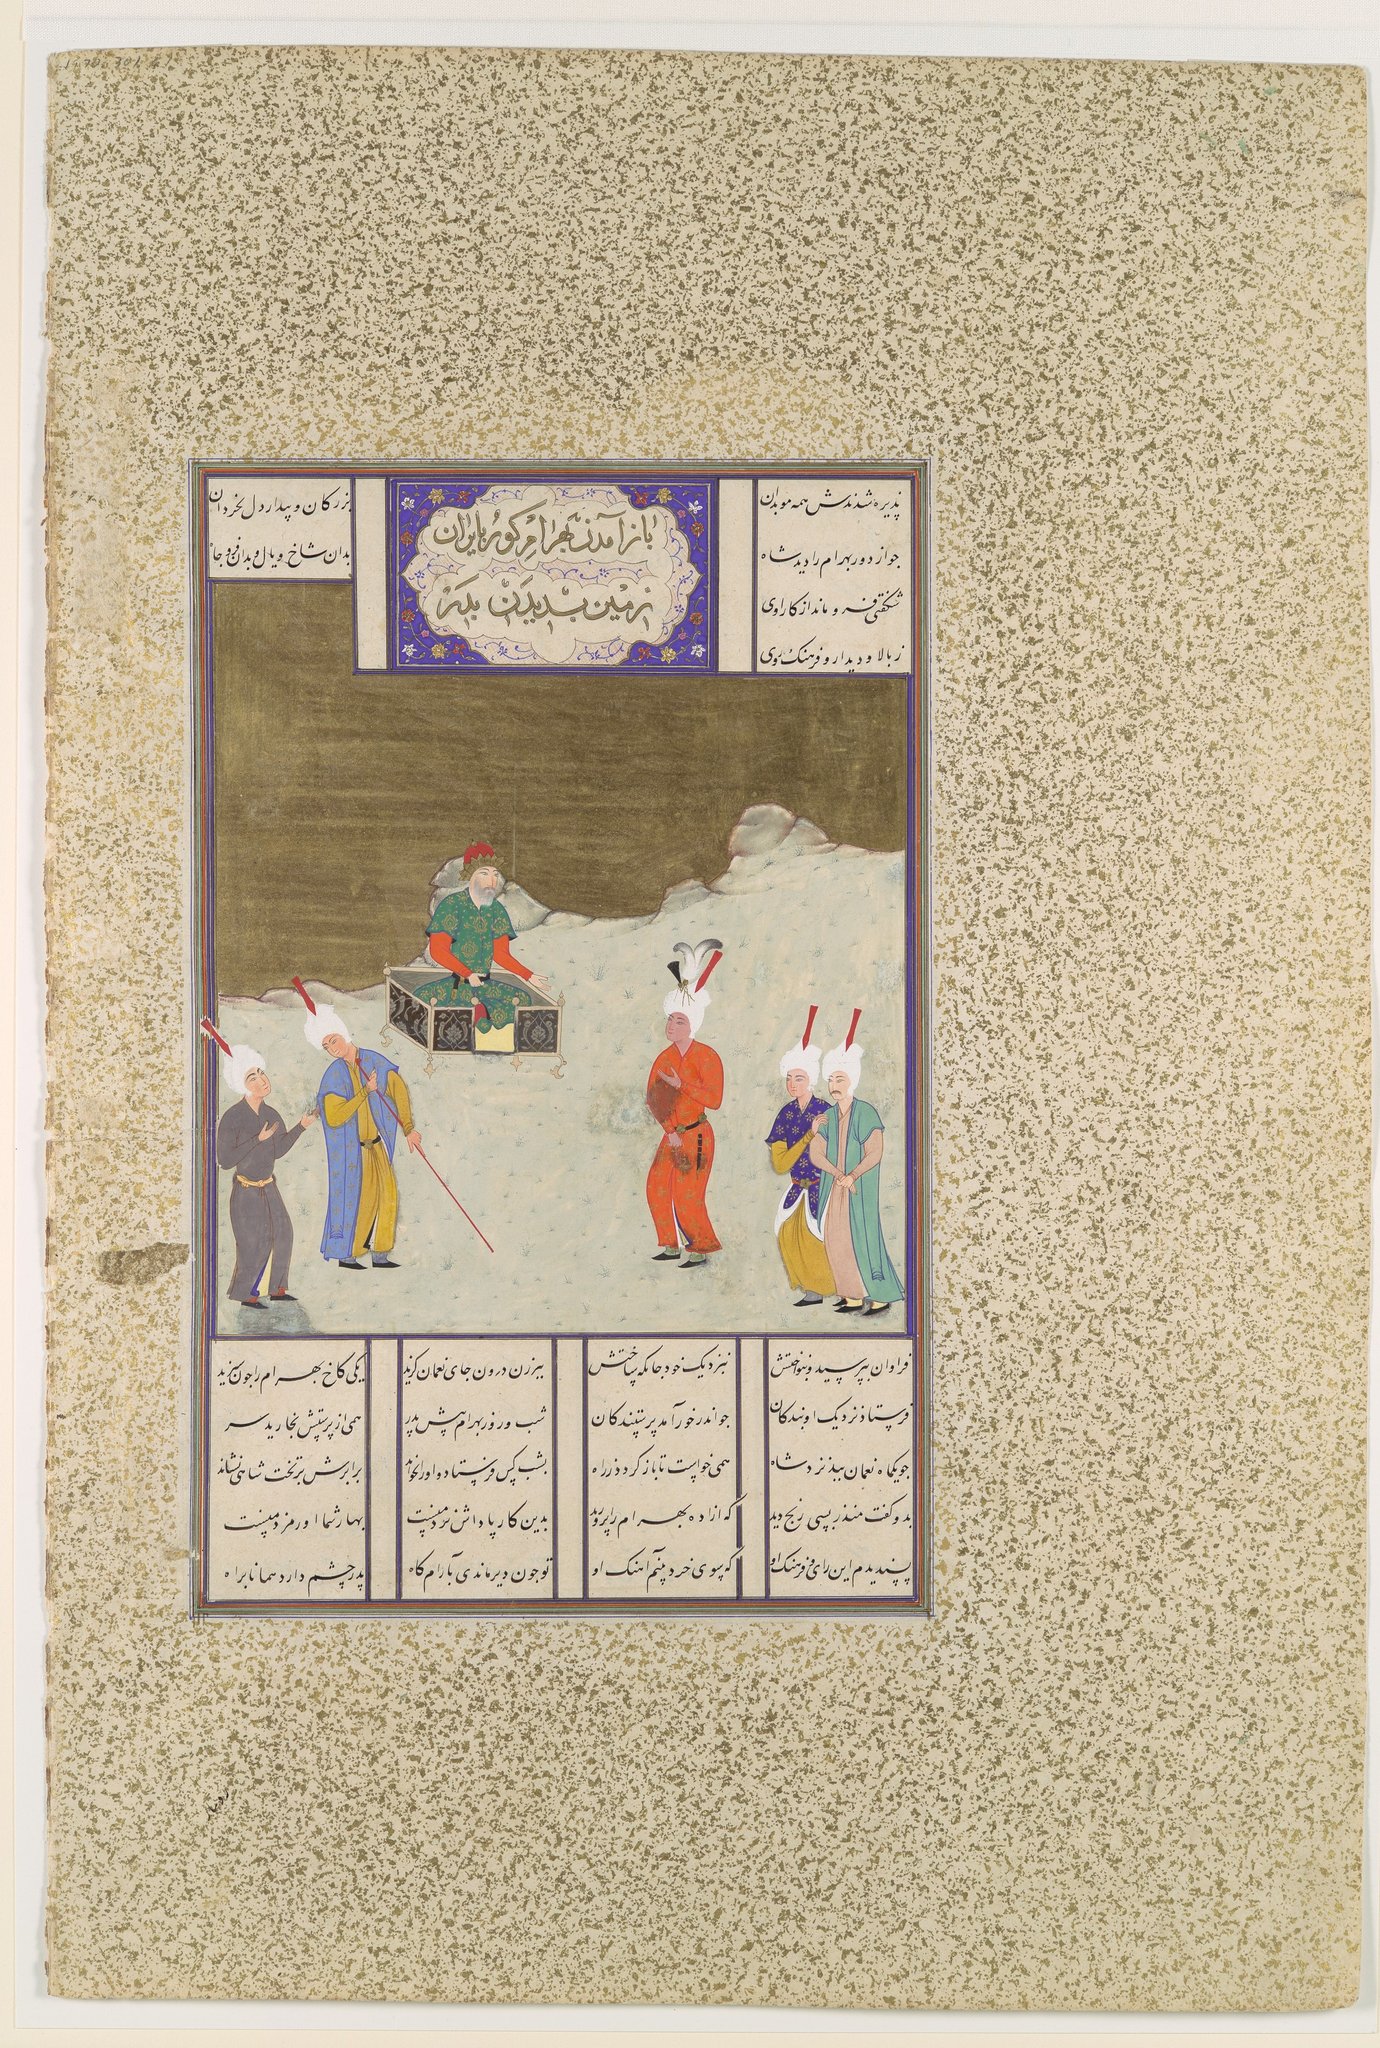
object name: folio from an illustrated manuscript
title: "Bahrum Gur Before His Father, Yazdigird I", Folio 551v from the Shahnama (Book of Kings) of Shah Tahmasp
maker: abu'l qasim firdausi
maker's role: author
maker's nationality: iranian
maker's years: 935-1020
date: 1530-1535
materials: gold, ink, paper, silver, watercolor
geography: iran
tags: kings,men